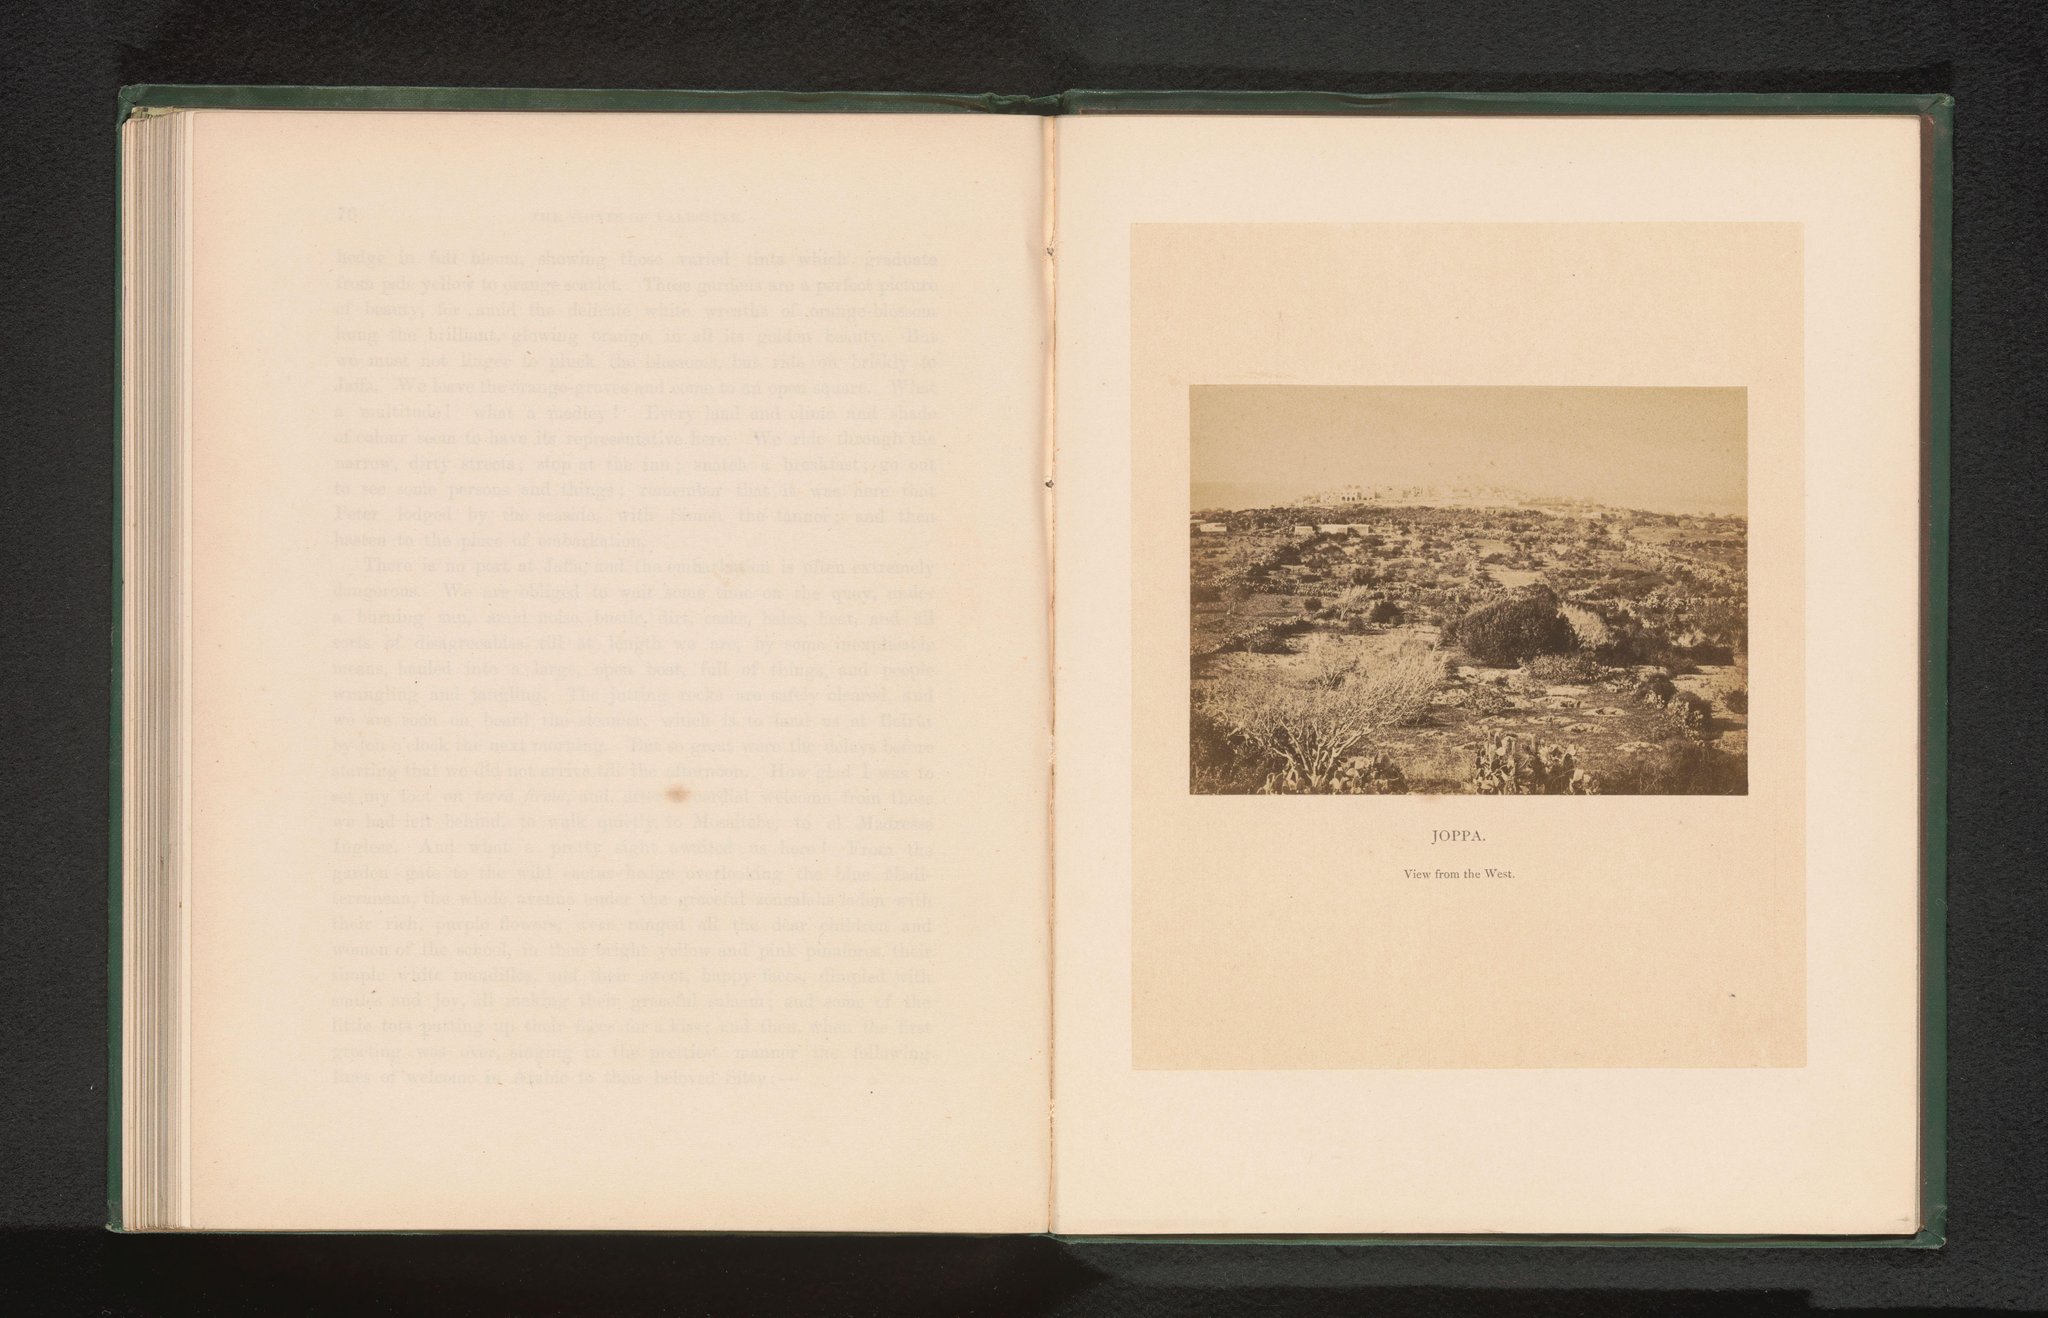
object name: page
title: Joppa. View from the West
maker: francis bedford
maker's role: print maker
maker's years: 1815-1894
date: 1860-1865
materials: photographic support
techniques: albumen print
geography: palestine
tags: city-view in general; 'veduta'